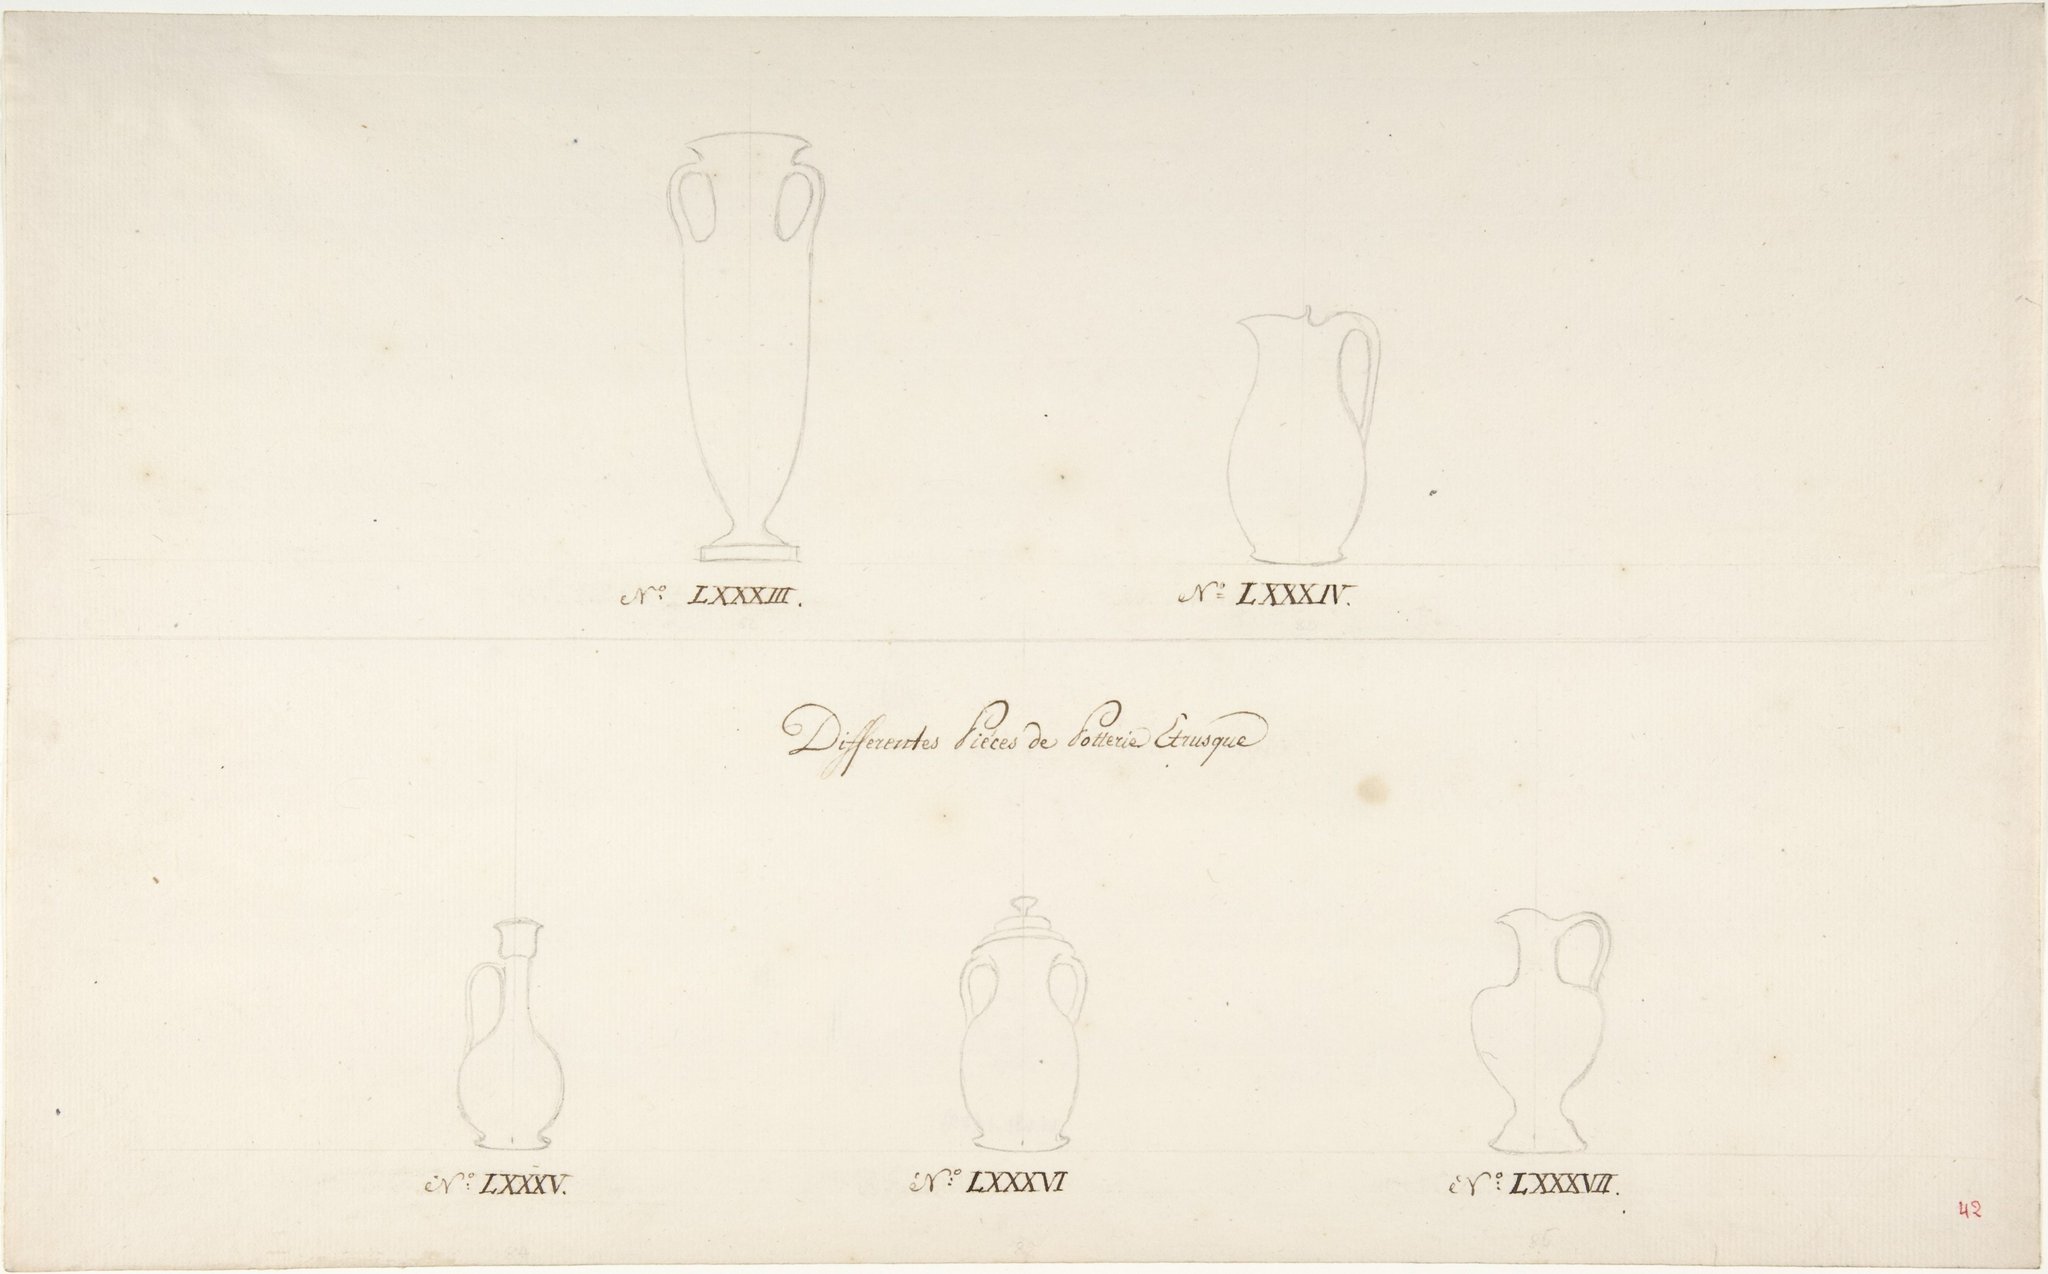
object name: drawing ornament architecture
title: Design for Five Vases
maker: anonymous, french, 18th century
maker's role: artist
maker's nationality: french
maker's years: 1700-1800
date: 1770-1785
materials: chalk, ink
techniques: pen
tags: vases